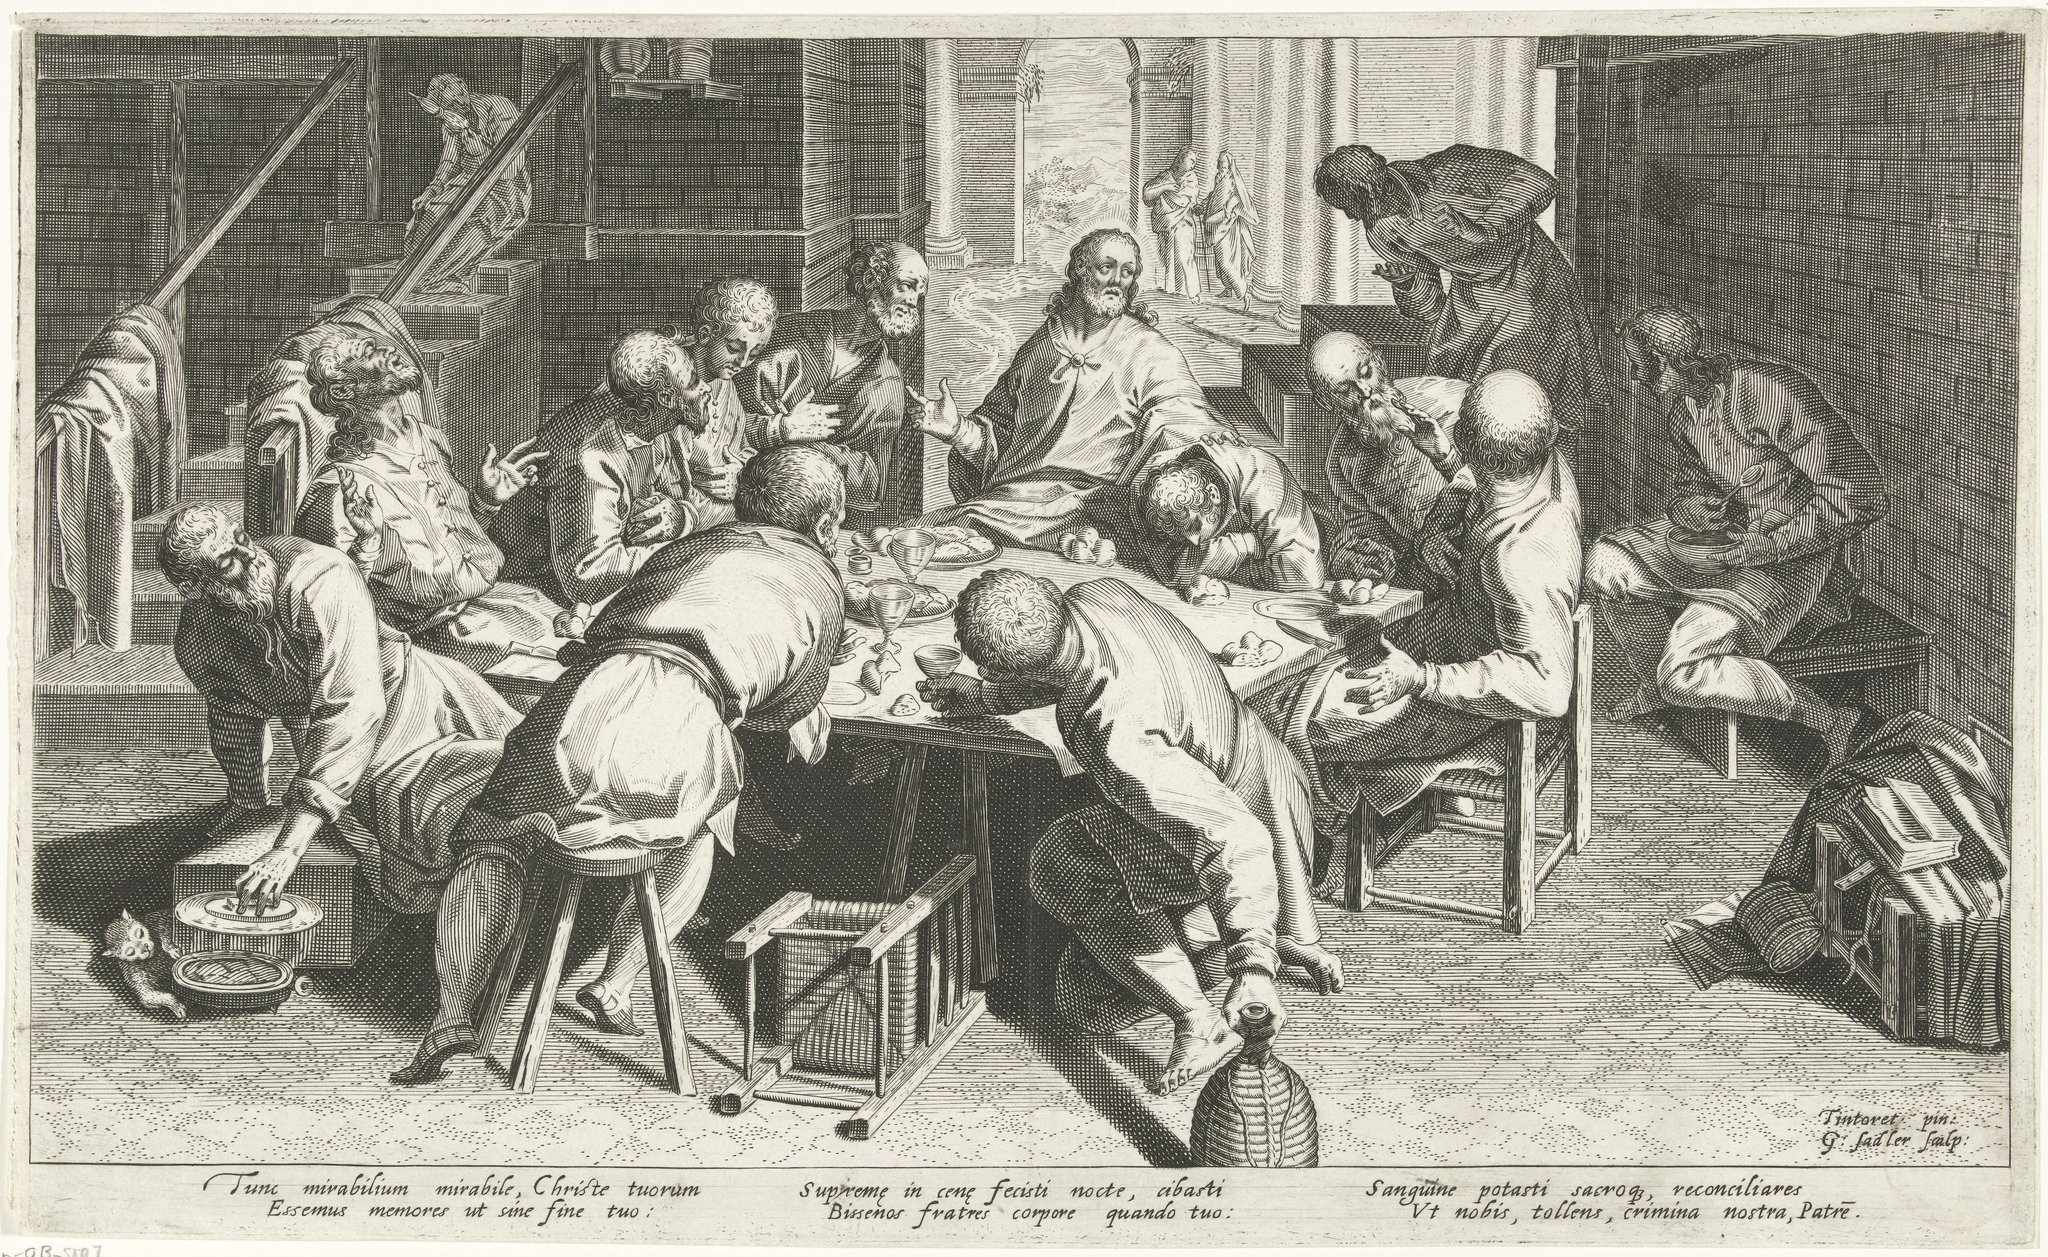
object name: print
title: Laatste avondmaal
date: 1580-1629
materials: paper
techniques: engraving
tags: last supper (in general) (matthew 26:21-35; mark 14:18-31; luke 22:3, 22:15-23; john 13:21-38)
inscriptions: collector's mark: Lugt 240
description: Christus zit samen met zijn leerlingen aan een rechthoekige tafel. Er wordt gegeten en gedronken. De prent heeft een Latijns onderschrift over dit Bijbelverhaal.